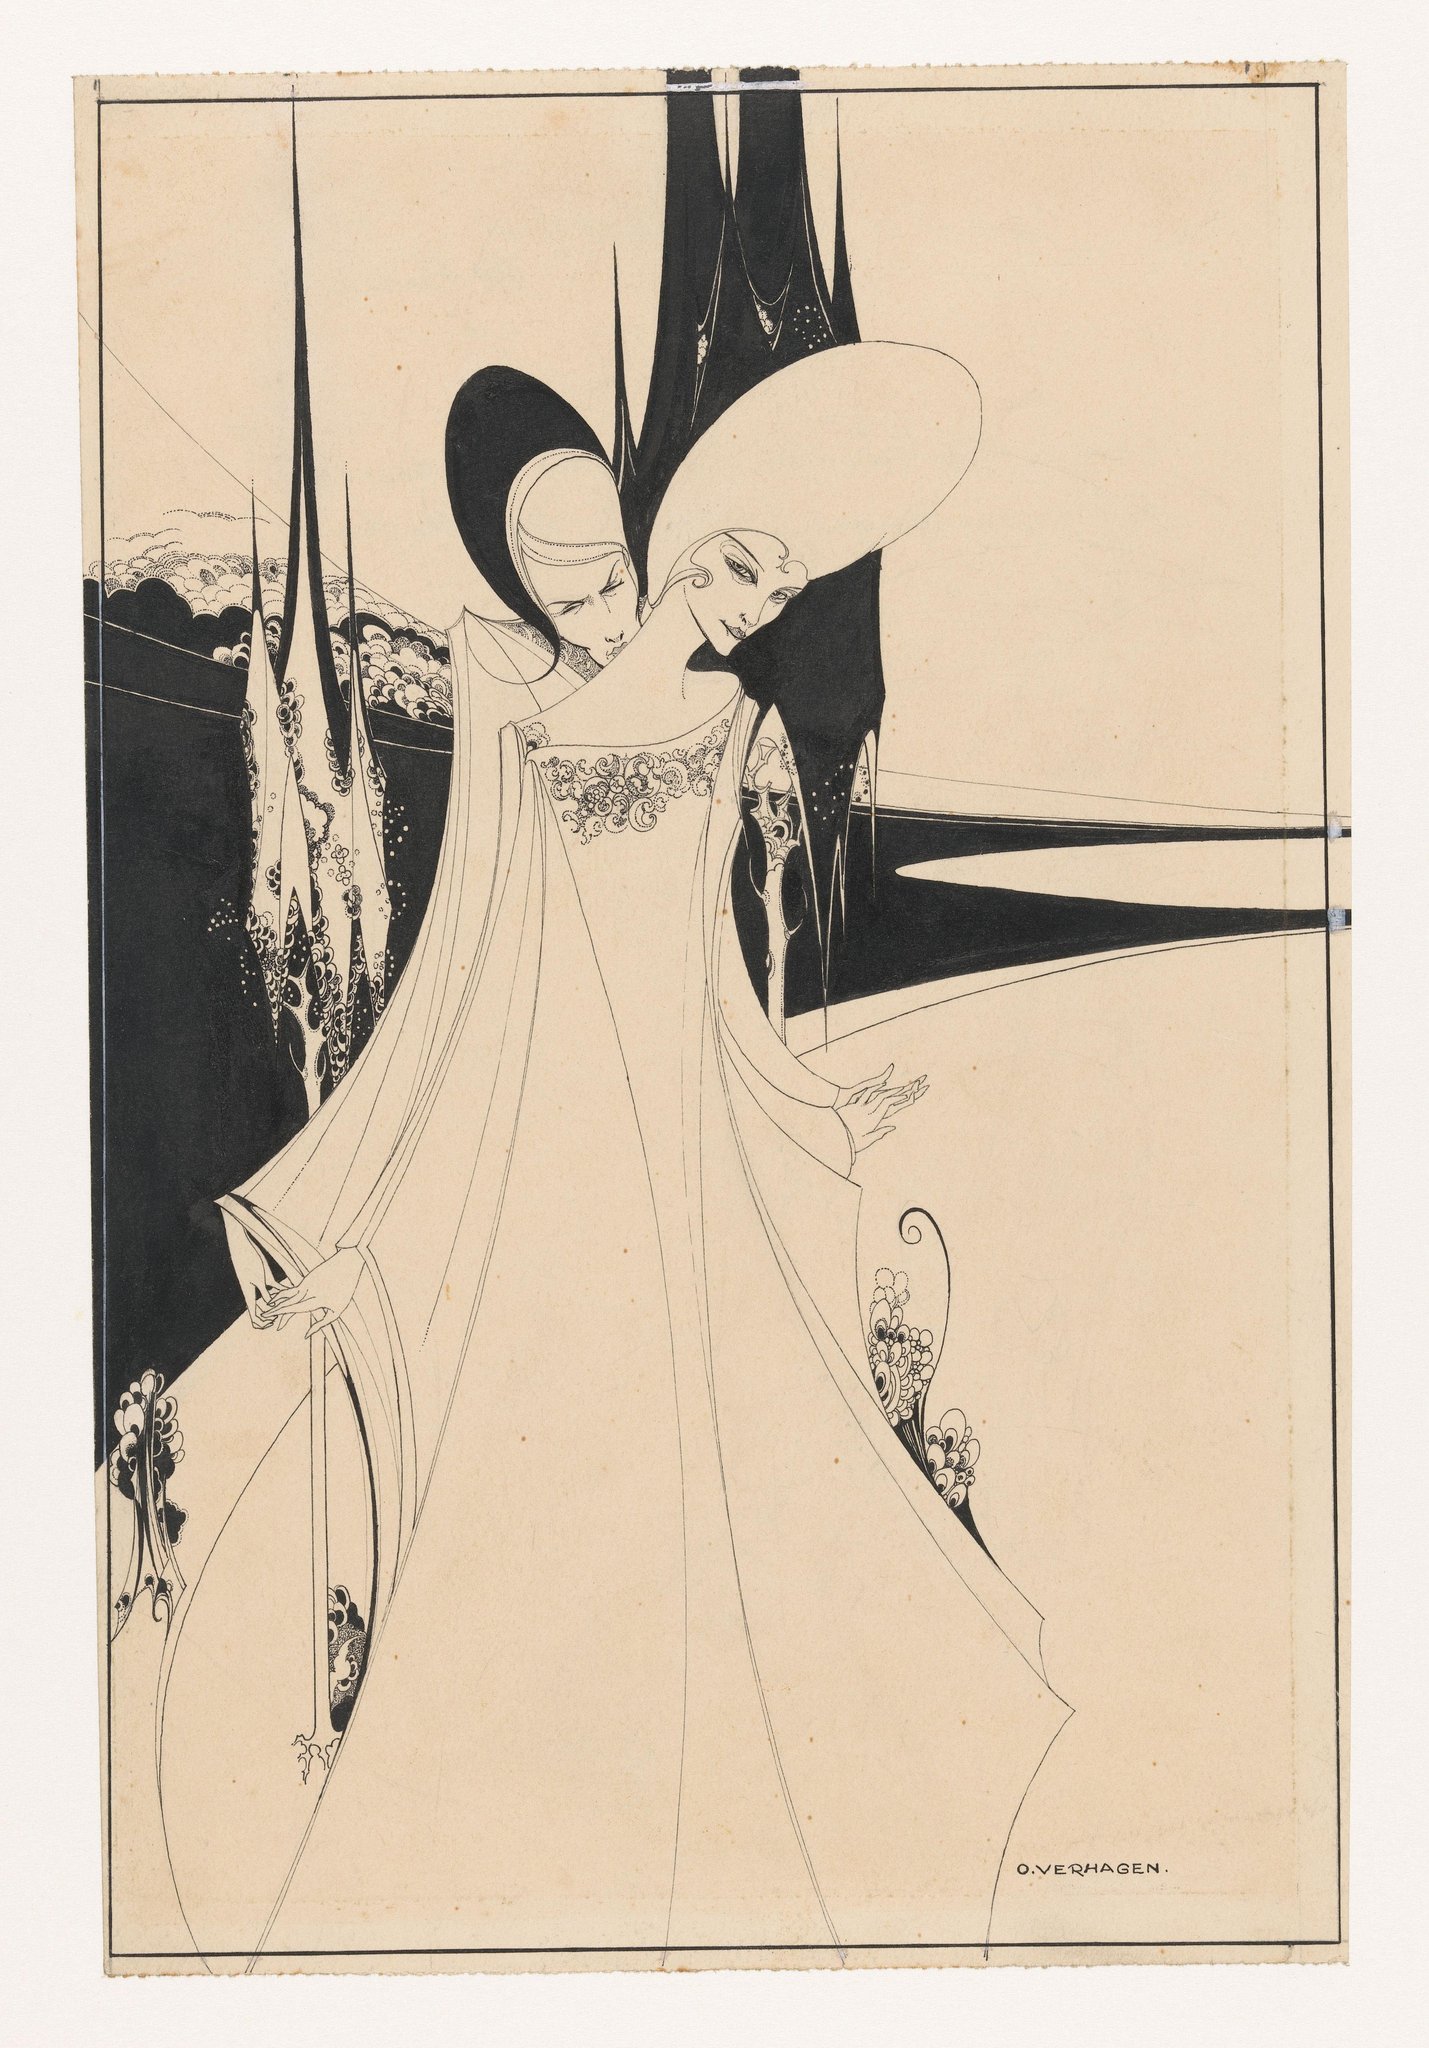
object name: drawing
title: Vrouw kust een andere vrouw in haar nek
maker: otto verhagen (i)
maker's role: draughtsman, print maker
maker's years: 1885-1951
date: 1912-1951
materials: paint, ink, paper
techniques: brush, pen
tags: (verlaine, il baccio) specific works of literature (with author, title)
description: Ontwerp voor: Verlaine, Paul. Il Baccio, Baiser-Rose Trémiereau Jardin des Caresses. Onbekende uitgave.